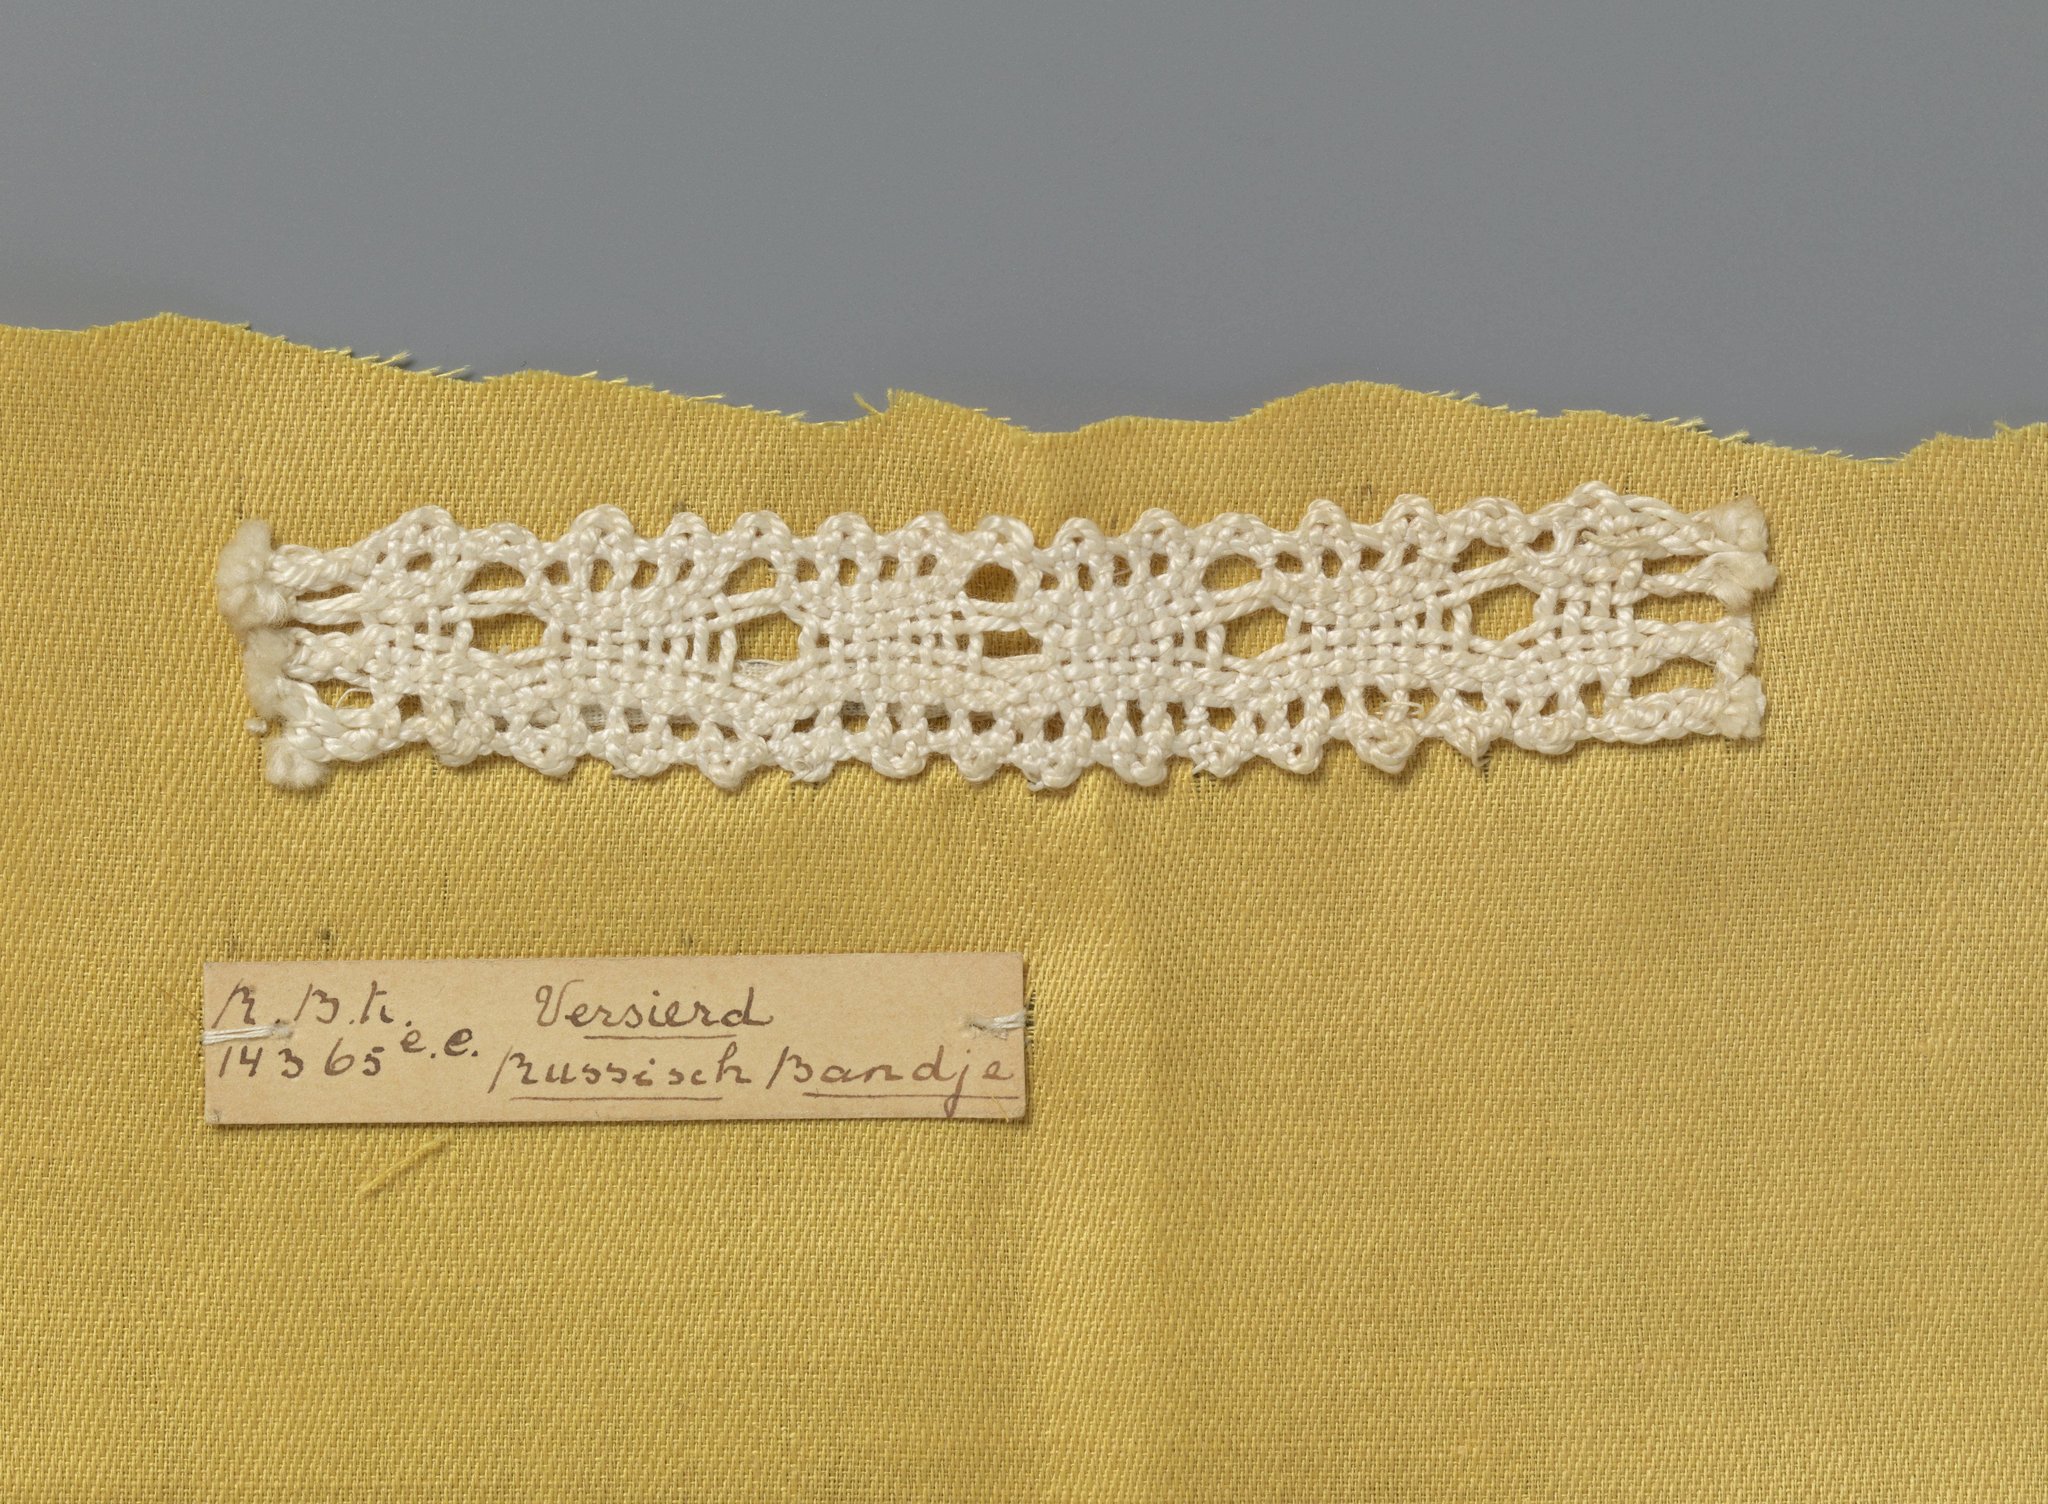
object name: sample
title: Staal kloskant met grove draad als voorbeeld van een lintje in linnenslag met uitsparingen dat wordt toegepast in Russische lintkant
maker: Anonymous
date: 1900-1930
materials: cotton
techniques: lace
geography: western europe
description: De stalen kloskant uit de serie BK-NM-14365 zijn al dan niet met bijpassend kantfragment en met handgeschreven labels op een stuk geel textiel genaaid van ongeveer 65x55 cm groot.